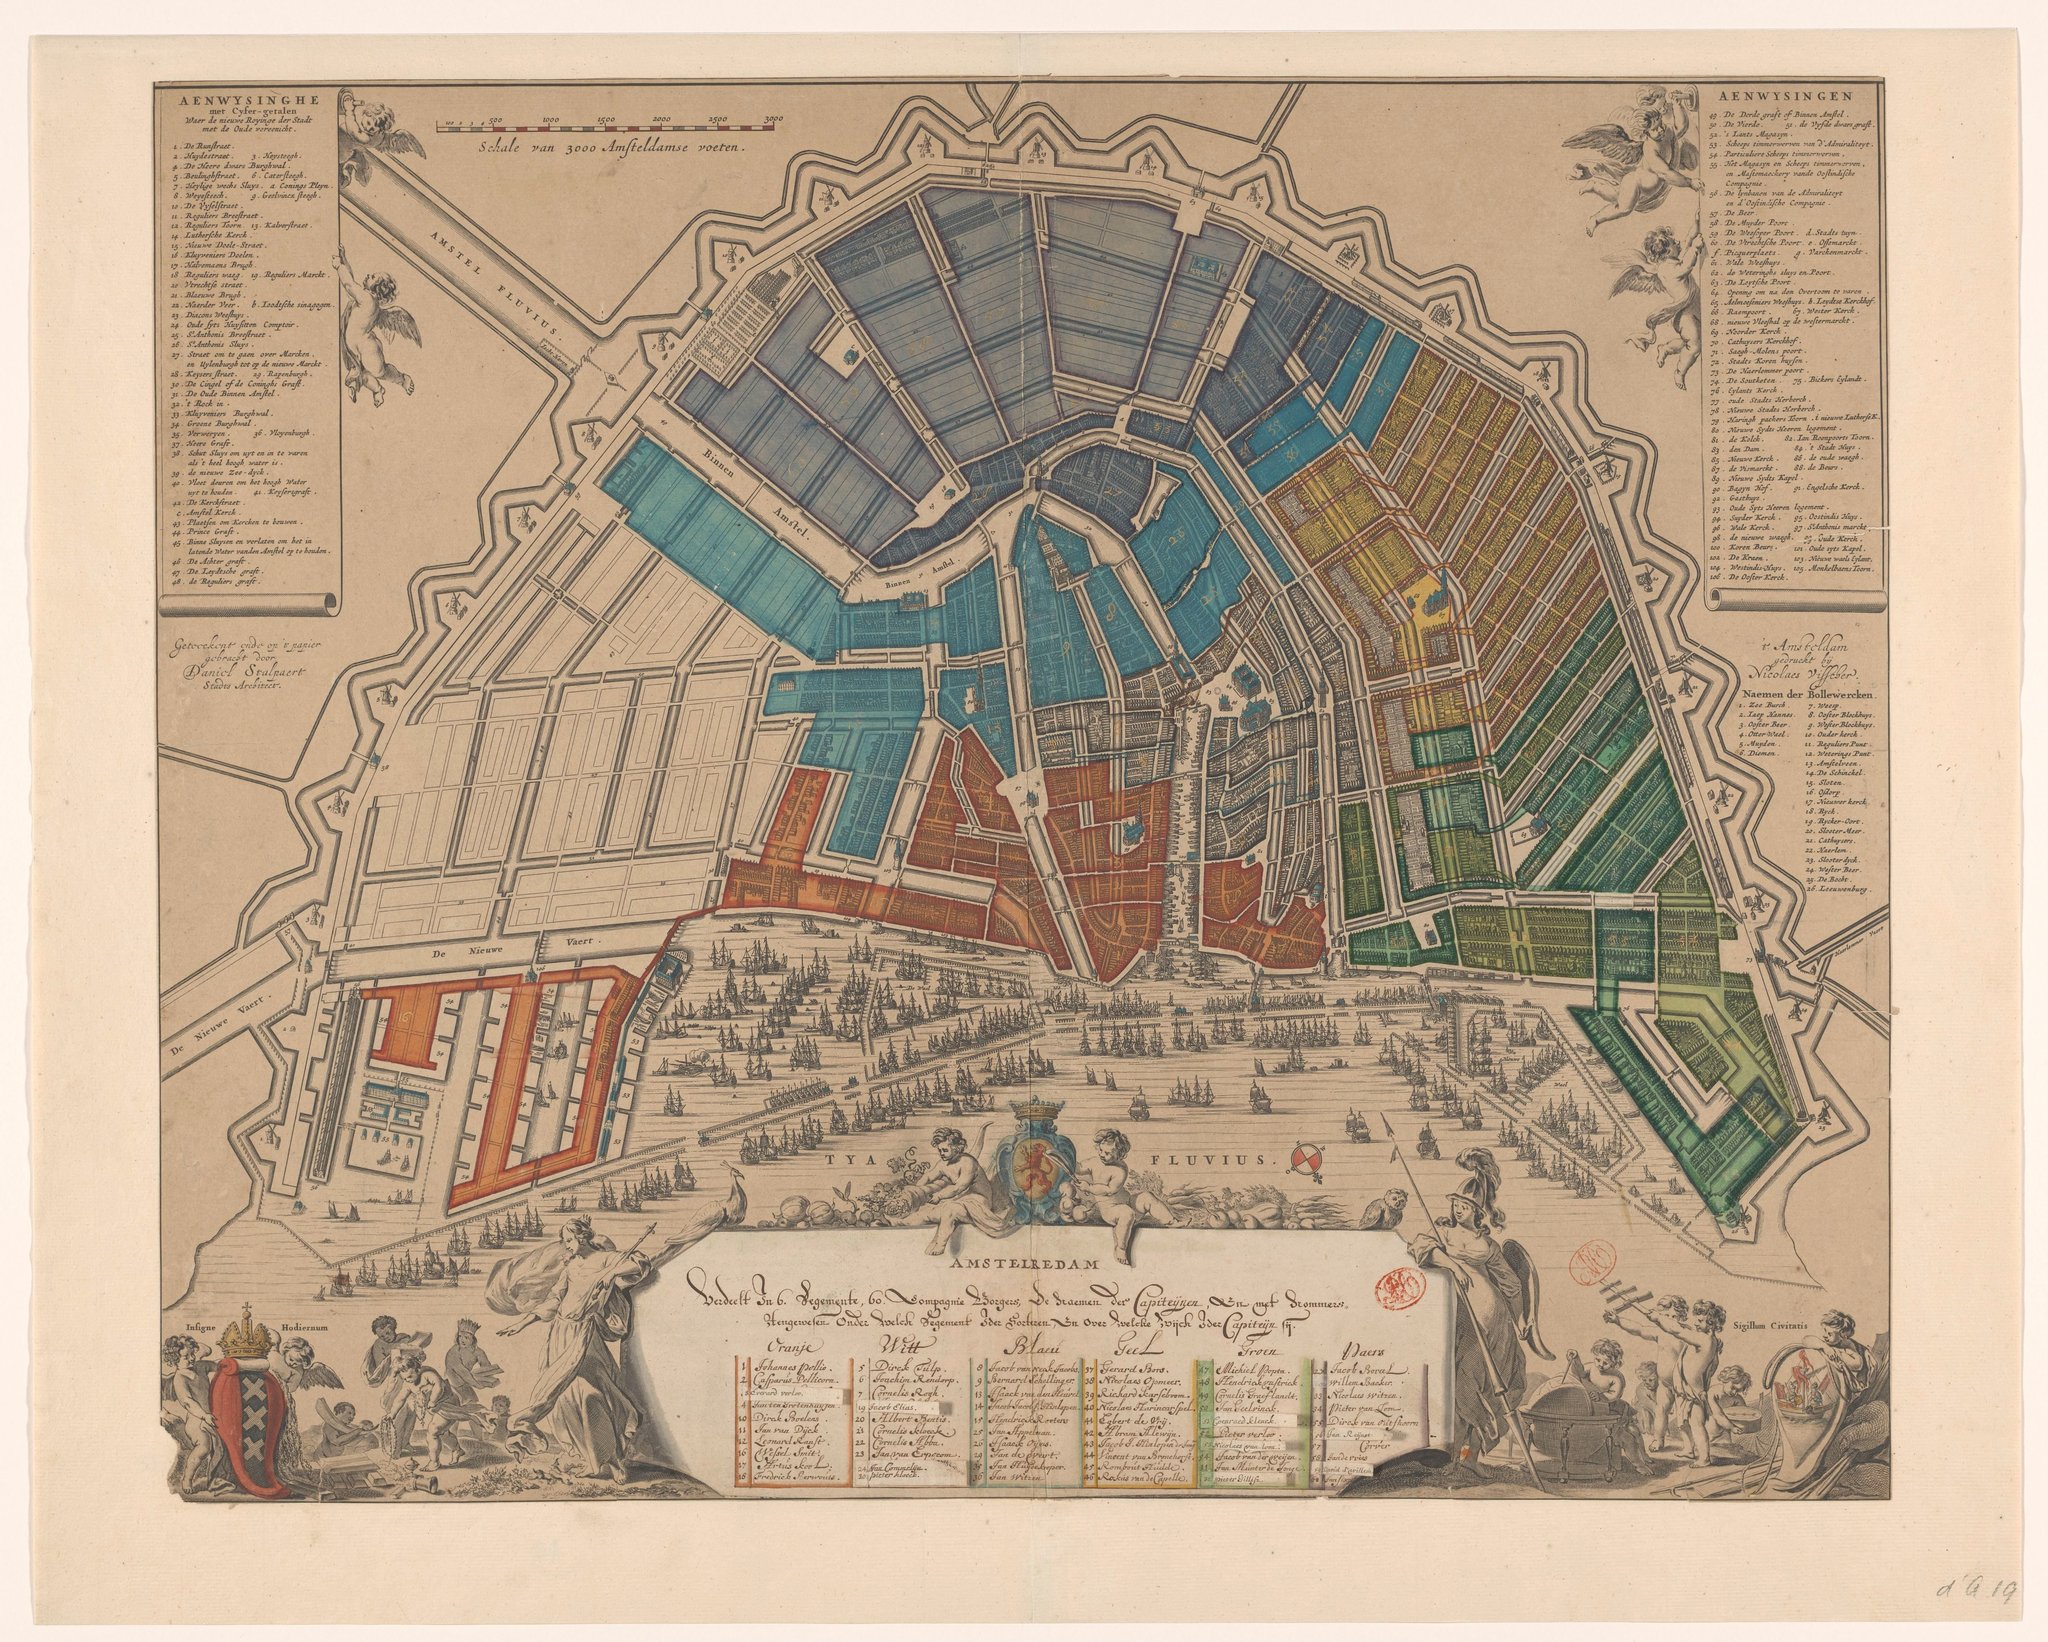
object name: print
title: Amstelodami veteris et novissimae urbis accuratissima delineatio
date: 1662-1664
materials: ink, paper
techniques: engraving, etching, hand coloring, pen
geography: amsterdam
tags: coat of arms (as symbol of the state, etc.) (+ city; municipal), (story of) juno (hera), (story of) minerva (pallas, athena), seal (as symbol of the state, etc.) (+ city; municipal), attributes of minerva: owl, globe, maps of cities, continents represented allegorically, trade, commerce and finance, position-finding at sea; nautical instruments, coat of arms (as symbol of the state, etc.) (+ province; provincial), prospect of city, town panorama, silhouette of city, amsterdam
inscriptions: inscription: ‘Amstelredam Verdeelt In 6. Regemente, 60. Compagnie Borgers, De Naemen der Capiteijnen, En met Nommers Aengewesen Onder Welck Regement Ider Sorteren, En Over Welcke Wijck Ider Capiteijn sij (...)’, collector's mark: Lugt 195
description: De datering (1669-1673) is de datering van de staat van de prent en is niet gebaseerd op het aantal burgerwijken of de namen van de kapiteins van de burgerwachten. Vermoedelijk zijn deze namen - zowel de namen die op het opgeplakte stuk papier staan als de namen op de daaroverheen geplakte strookjes papier - echter niet lang na het verschijnen van de prent aangebracht. Over Joan Blaeu, die in 1673 overleed, is een strookje met de naam van Jacob Elias geplakt. Over bijvoorbeeld Nicolaes van Loon, die in 1676 overleed, is dit niet gedaan en zijn ook geen sporen van een afgevallen strookje te vinden. Zie RP-P-AO-20-45 voor eerdere staat en RP-P-AO-20-45A, RP-P-AO-20-48 (met indeling burgerwijken) en RP-P-AO-20-84 voor latere staten. Voor een soortgelijke kaart in de collectie van het Stadsarchief Amsterdam zie: http://beeldbank.amsterdam.nl/afbeelding/010035000048.